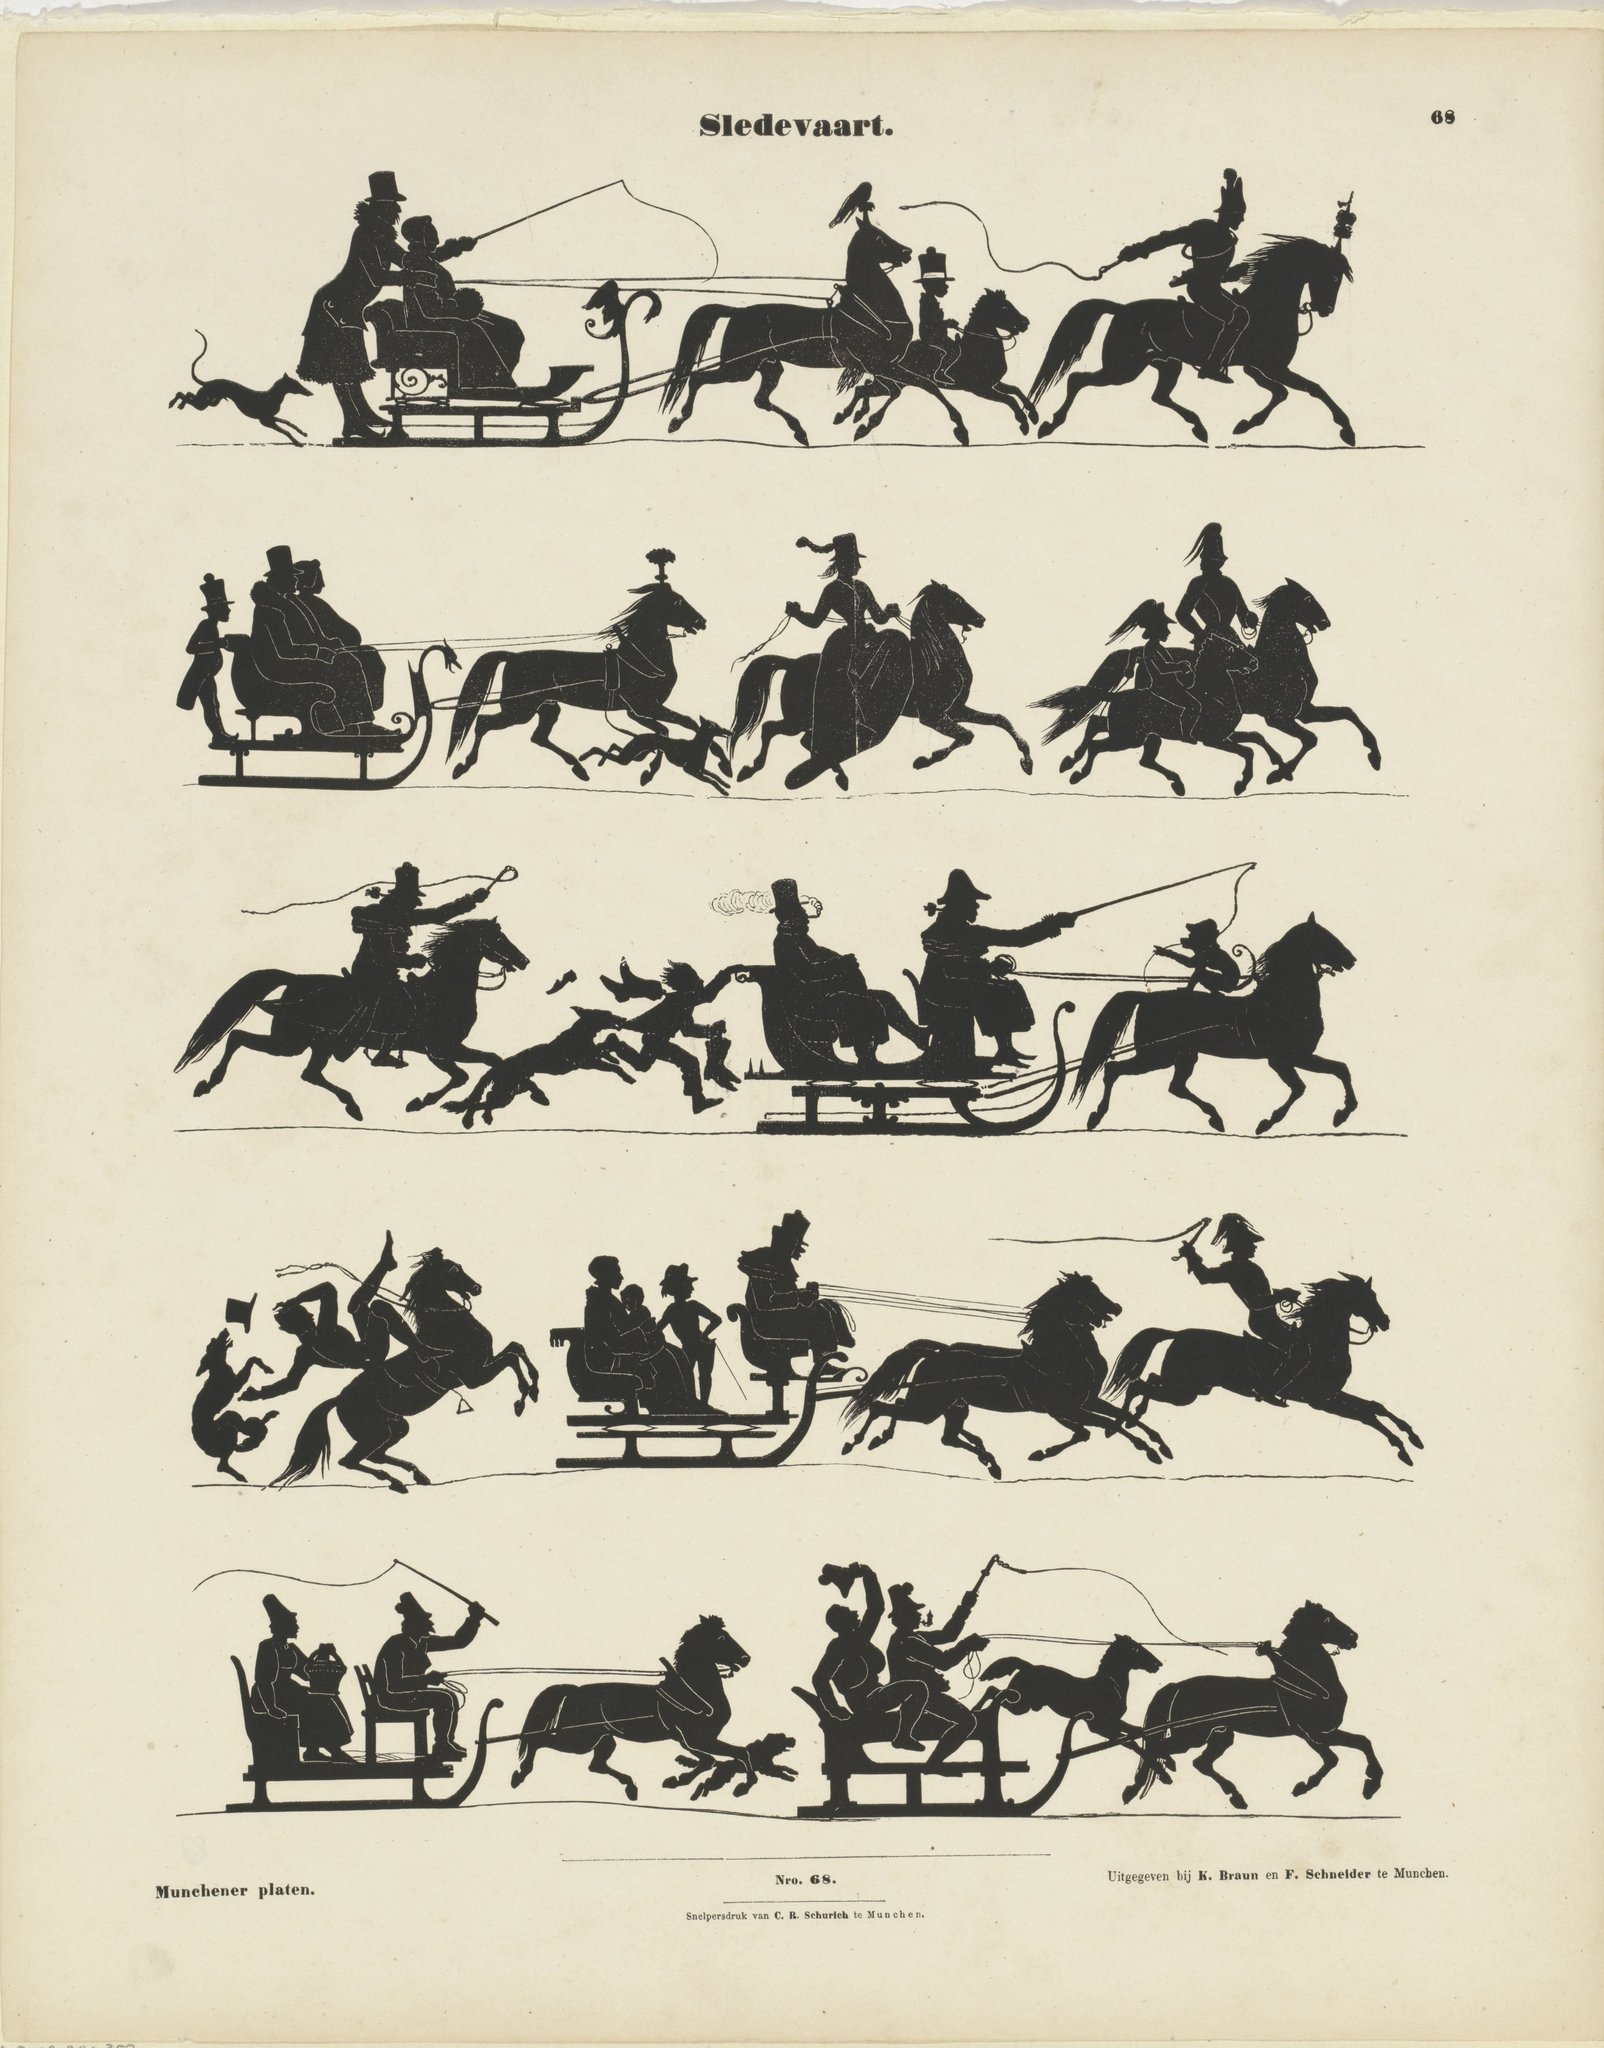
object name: popular print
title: Munchener platen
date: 1843-1920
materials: paper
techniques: letterpress printing, engraving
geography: germany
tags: magic, supernaturalism, occultism, violin, fiddle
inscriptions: collector's mark: Lugt 2760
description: Blad met 5 horizontale rijen met voorstellingen van silhouetten van door paarden getrokken sleden voor een schimmenspel. Genummerd midden onder: Nro. 68. Genummerd rechtsboven: 68.